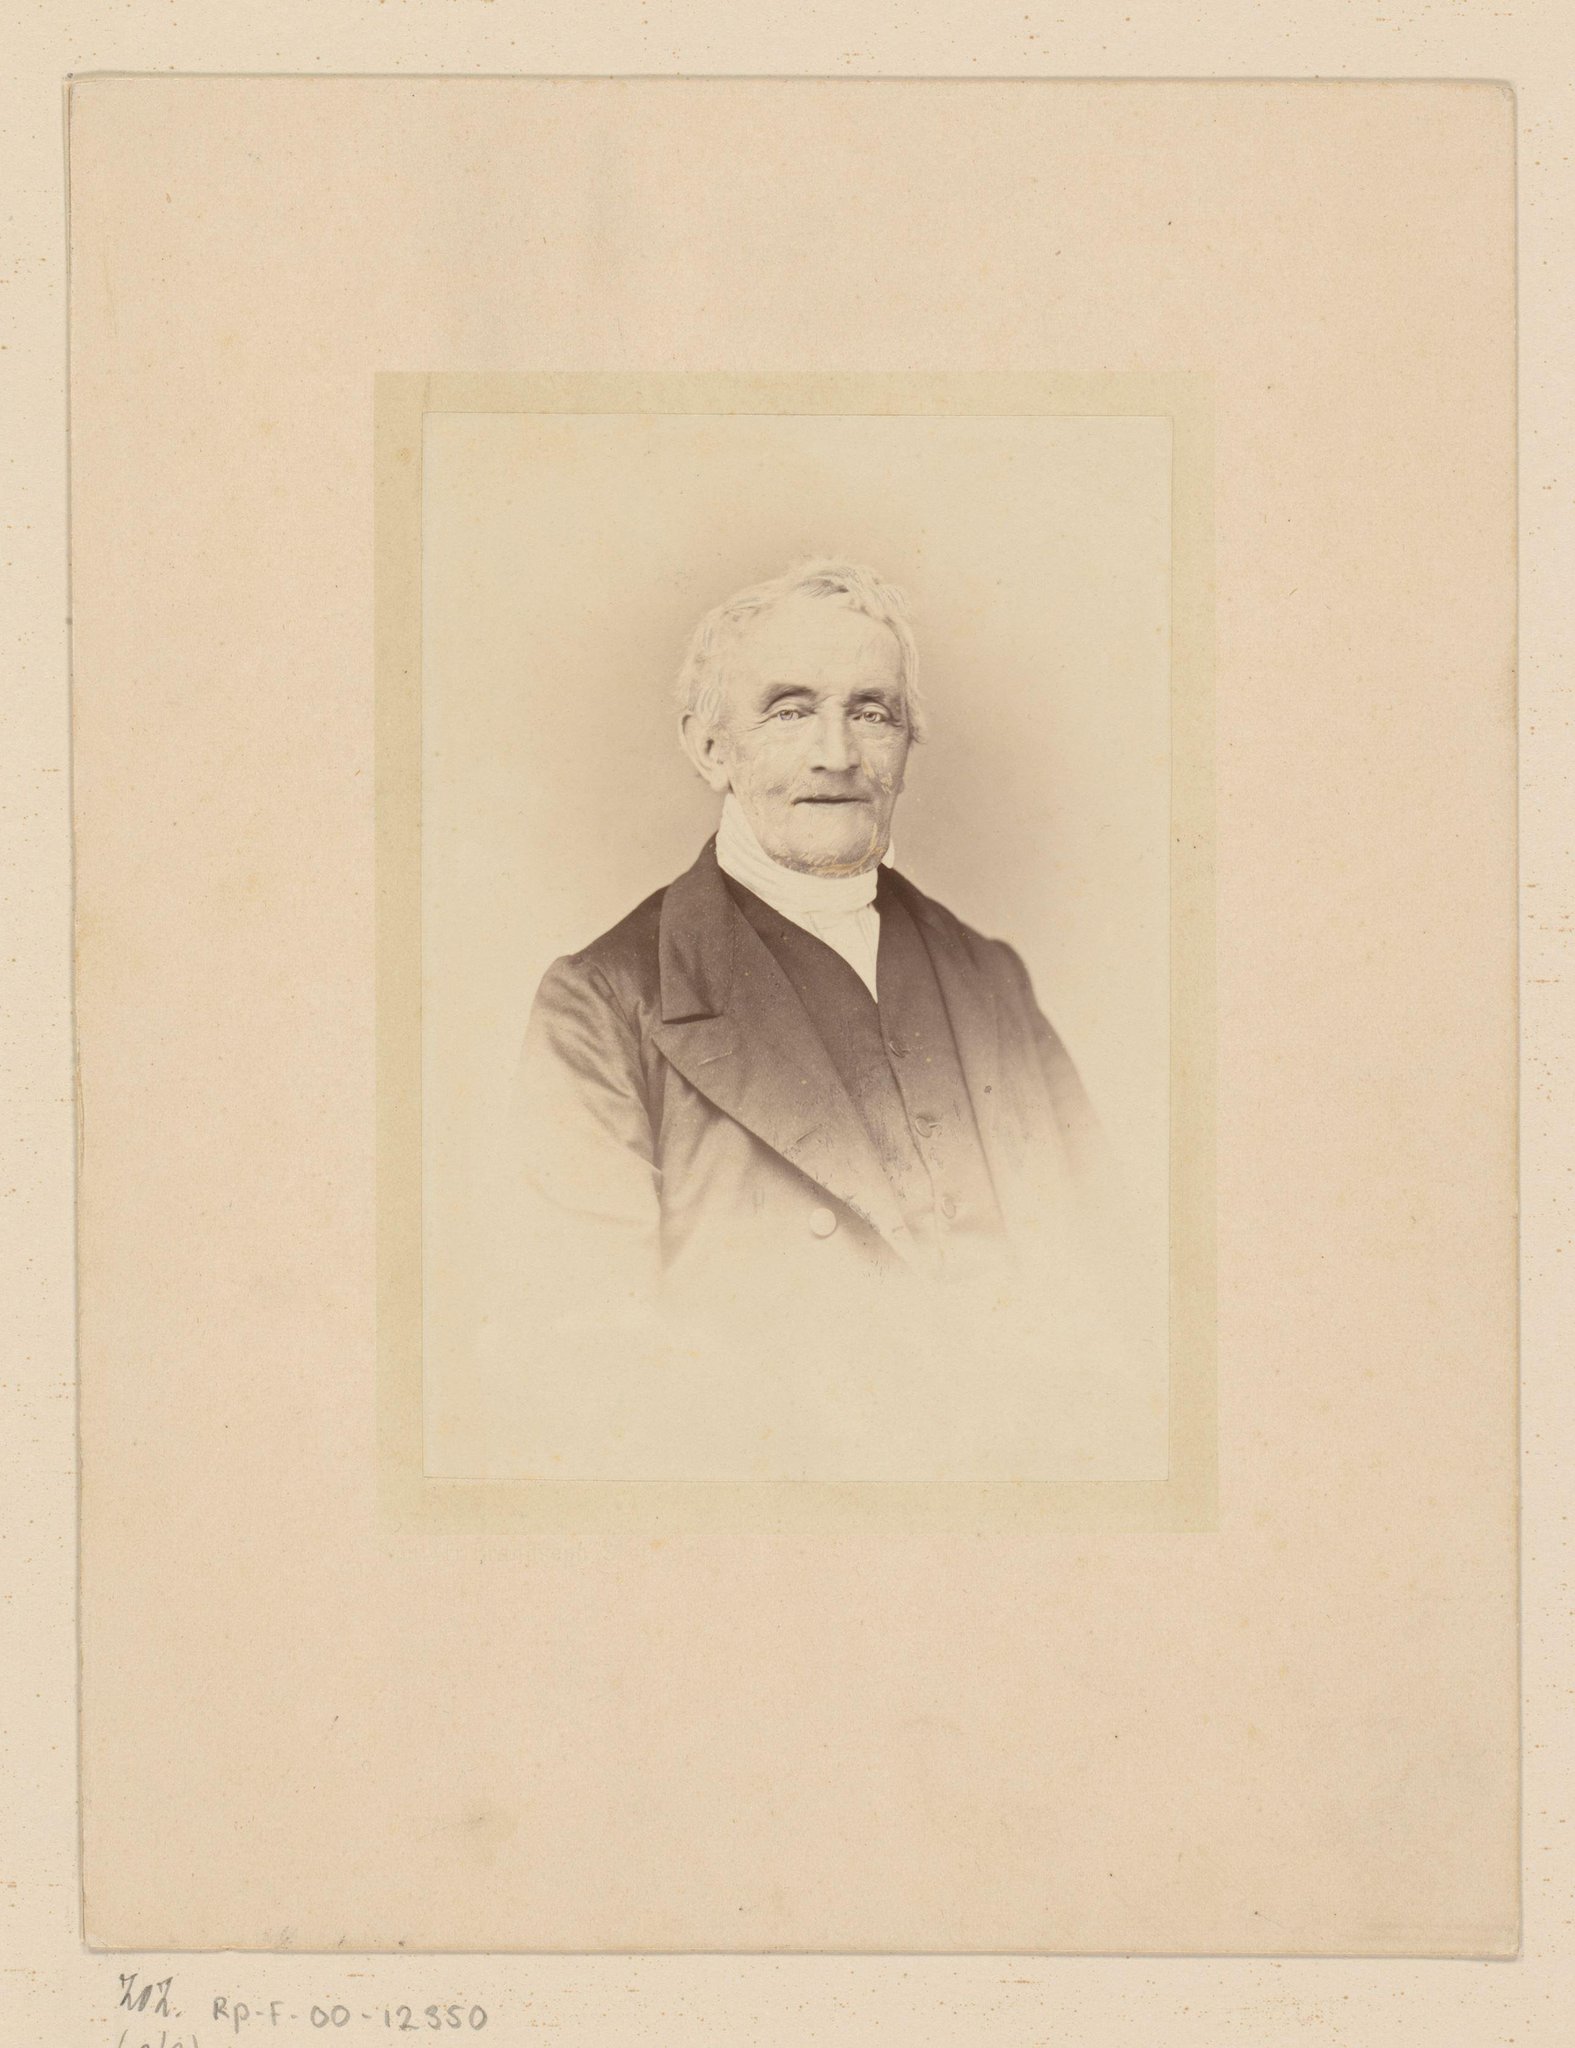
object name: photograph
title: Portret van Willem Hendrik Suringar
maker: Anonymous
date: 1851-1868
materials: cardboard, paper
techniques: albumen print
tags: historical persons, lawyer, attorney at law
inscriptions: inscription: ‘Van W.H. Suringar ontvangen,/ der 31e December 1868/ Adv P.J. Koch./ H.H.L. overleed 17 Sept: 1872 oud 82 jaren’